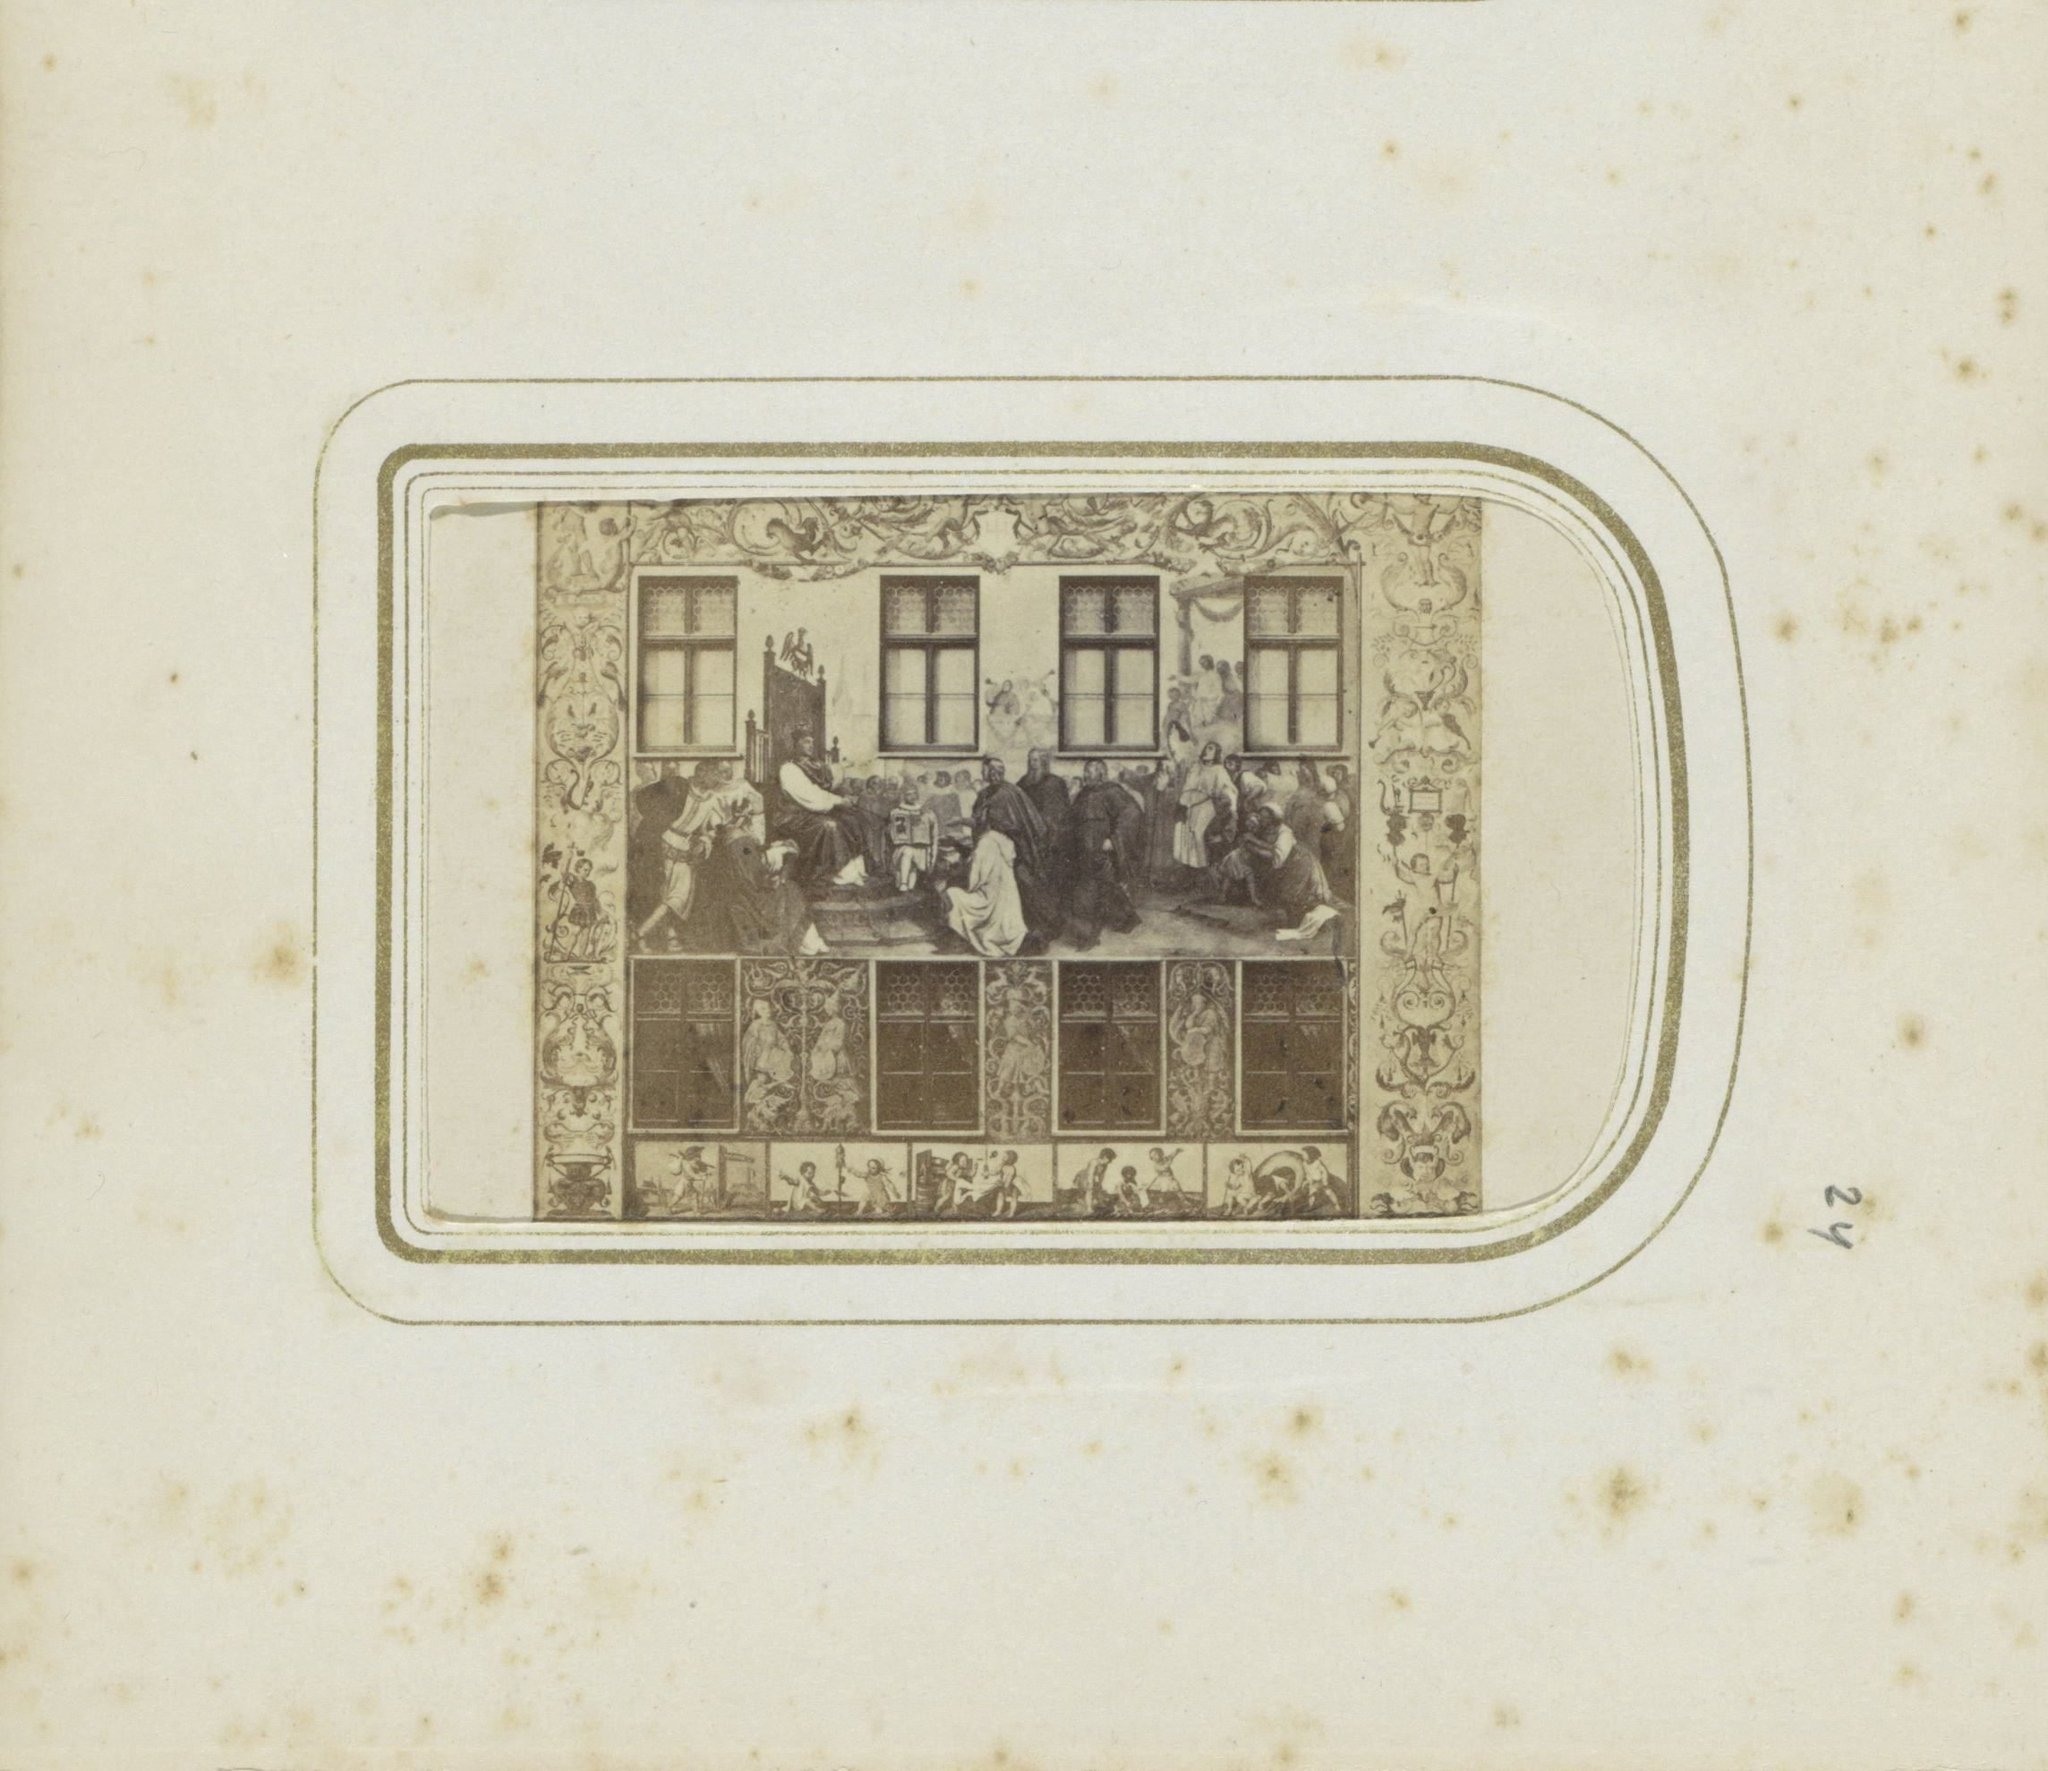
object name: photograph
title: Fresco op een gevel van het voormalige woonhuis van Hans Jakob Fugger in Augsburg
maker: Anonymous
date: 1865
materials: paper, photographic support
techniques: albumen print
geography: augsburg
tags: painting (including book-illumination, miniature-painting) (+ plaster ~ arts), travelling; tourism, augsburg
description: Onderdeel van Fotoalbum van een reis door Zwitserland, Oostenrijk en Duitsland door de Nederlandse familie Derkinderen.